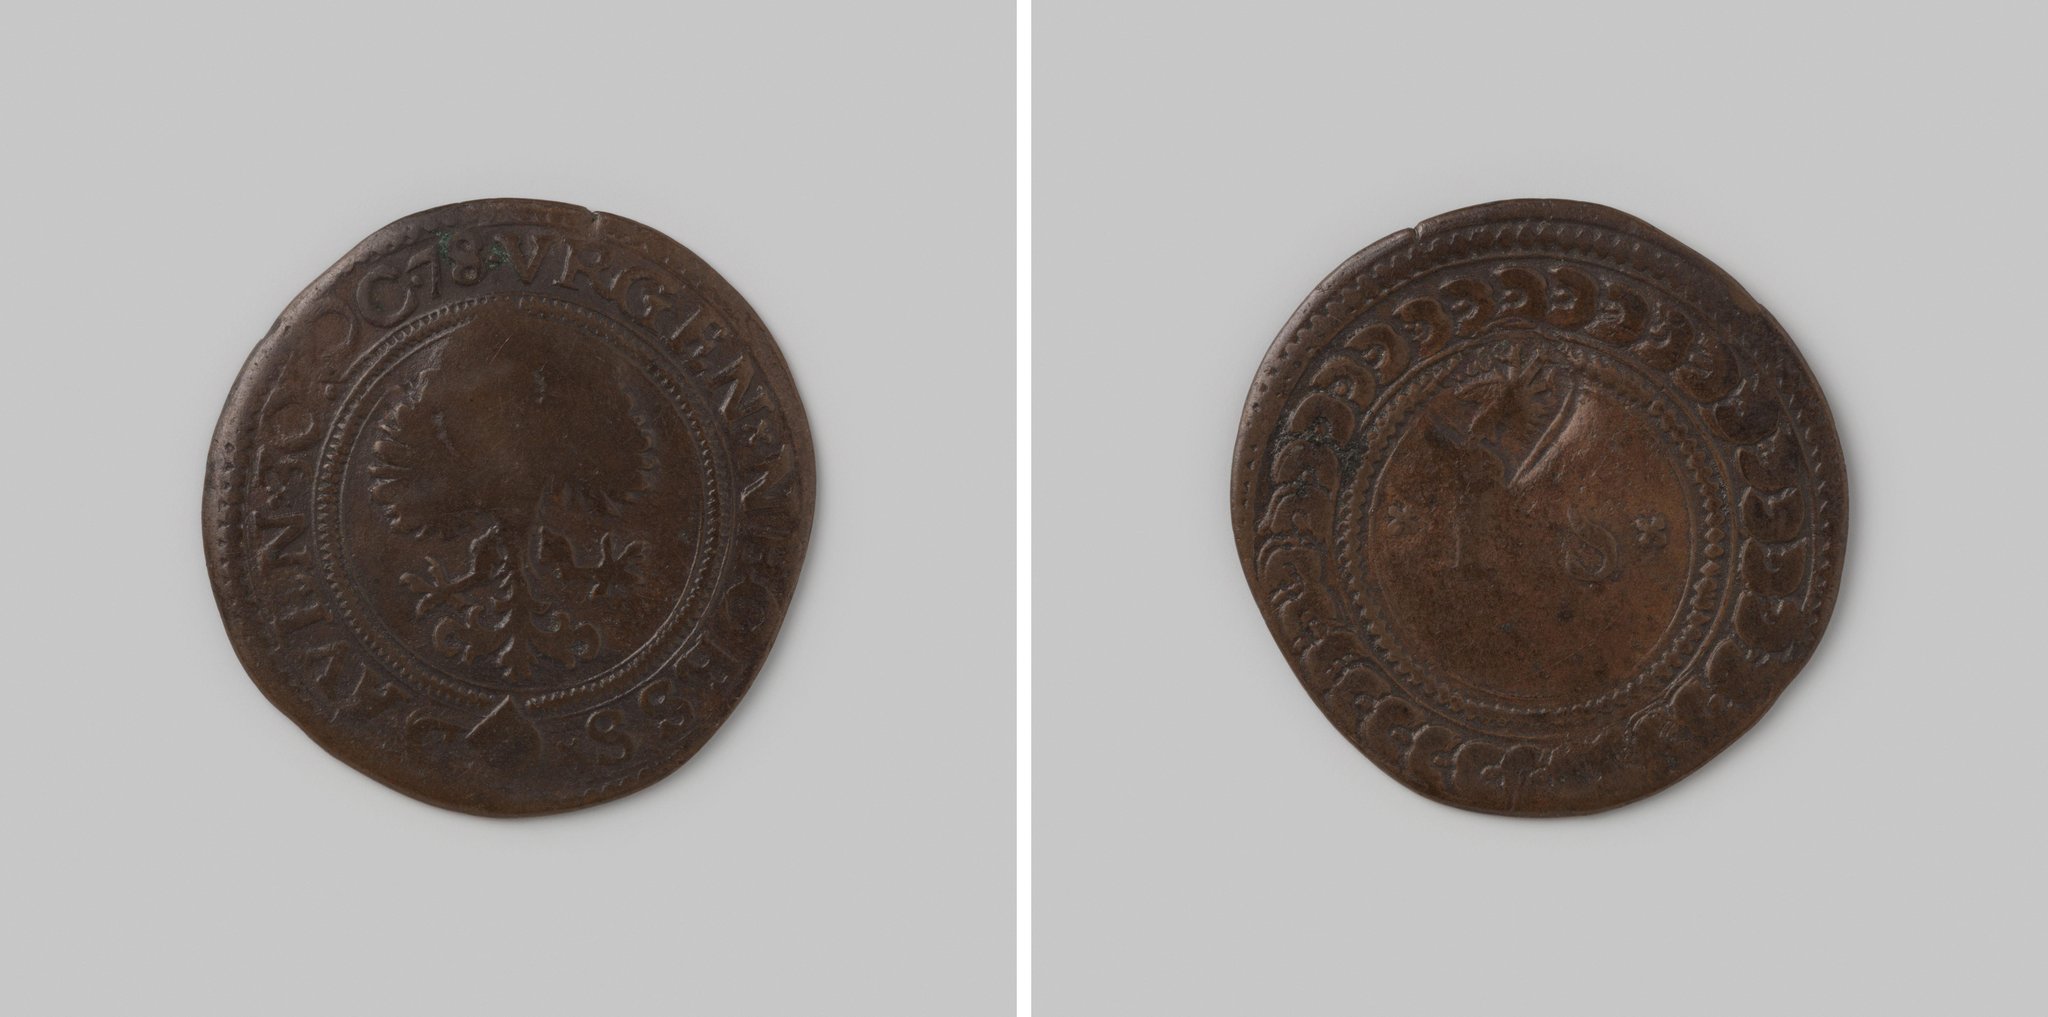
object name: stuiver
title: Stad Deventer, noodmunt van 1 stuiver, 1578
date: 1578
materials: copper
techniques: striking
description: Koperen noodmunt. Voorzijde: binnen parelcirkel gekroonde enkelkoppige adelaar naar links. Omschrift: Vrgen. Necess [stadswapenschildje] Daven. 30 Oc 78. Keerzijde: binnen parelcirkel op een regel waarde-aanduiding: I S. Buiten parelcirkel krans. Met klop stadswapenschildje?.